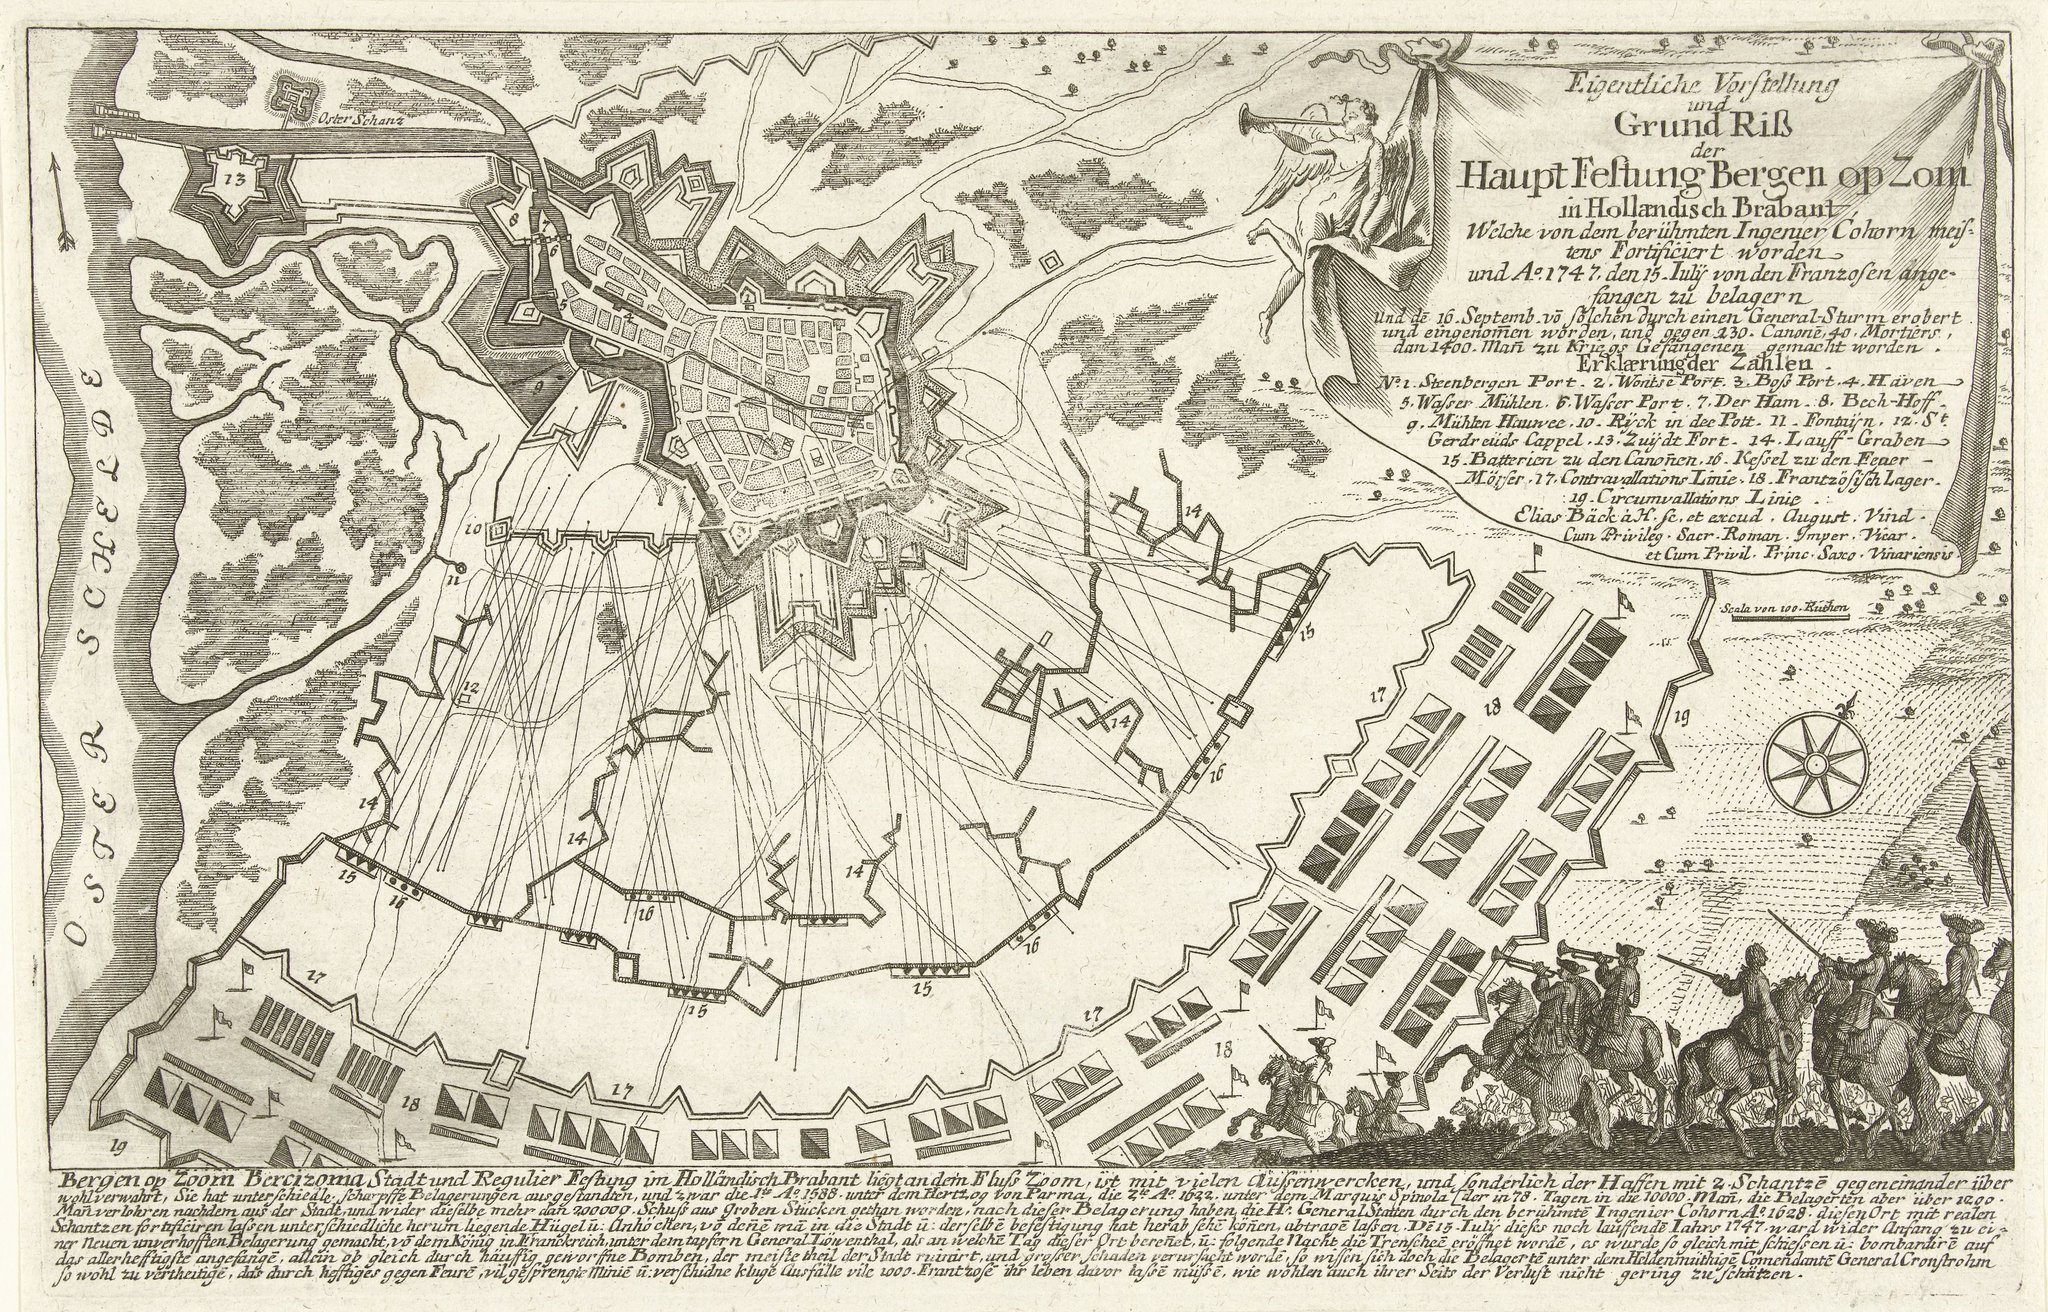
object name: print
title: Eigentliche Vorstellung und Grund Riß der Haupt Festung Bergen op Zom in Hollandisch Brabant (...) Ao. 1747 den 15. Iulij von den Franzosen angefangen zu belagern (...)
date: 1747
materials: paper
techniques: etching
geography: augsburg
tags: fortress, siege, position war, bergen op zoom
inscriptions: collector's mark: Lugt 2228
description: Kaartje met het beleg van de stad Bergen op Zoom door de Fransen, juli-september 1747. In het onderschrift een beshrijving van de stad and he beleg in het Duits. In de cartouche rechtsboven de titel en de legenda 1-19.